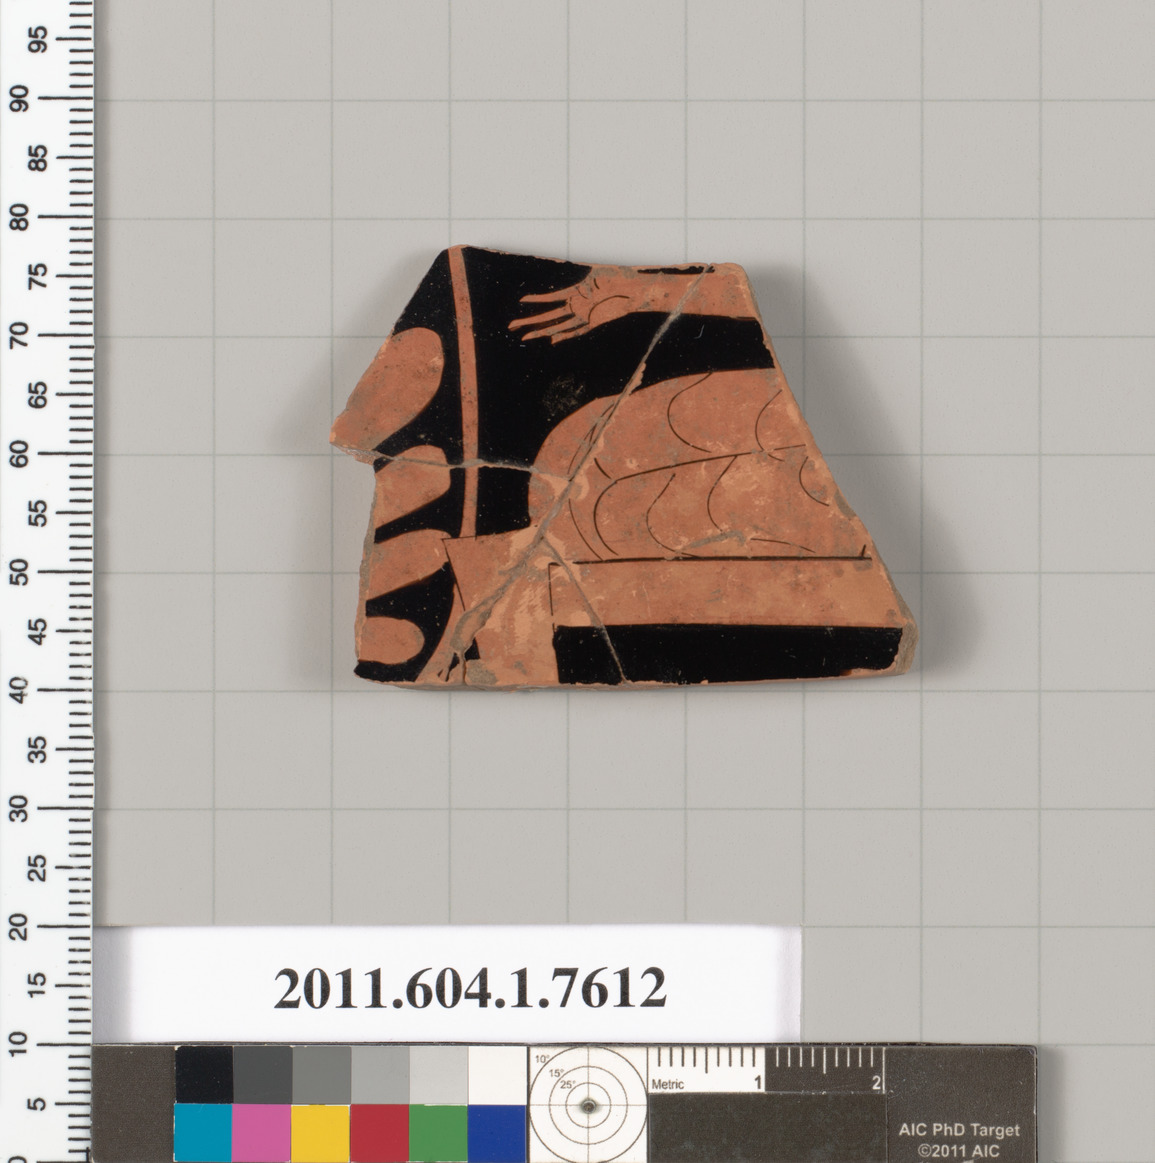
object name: kylix fragment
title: Terracotta fragment of a kylix (drinking cup)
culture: greek, attic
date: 460-450 BCE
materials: terracotta